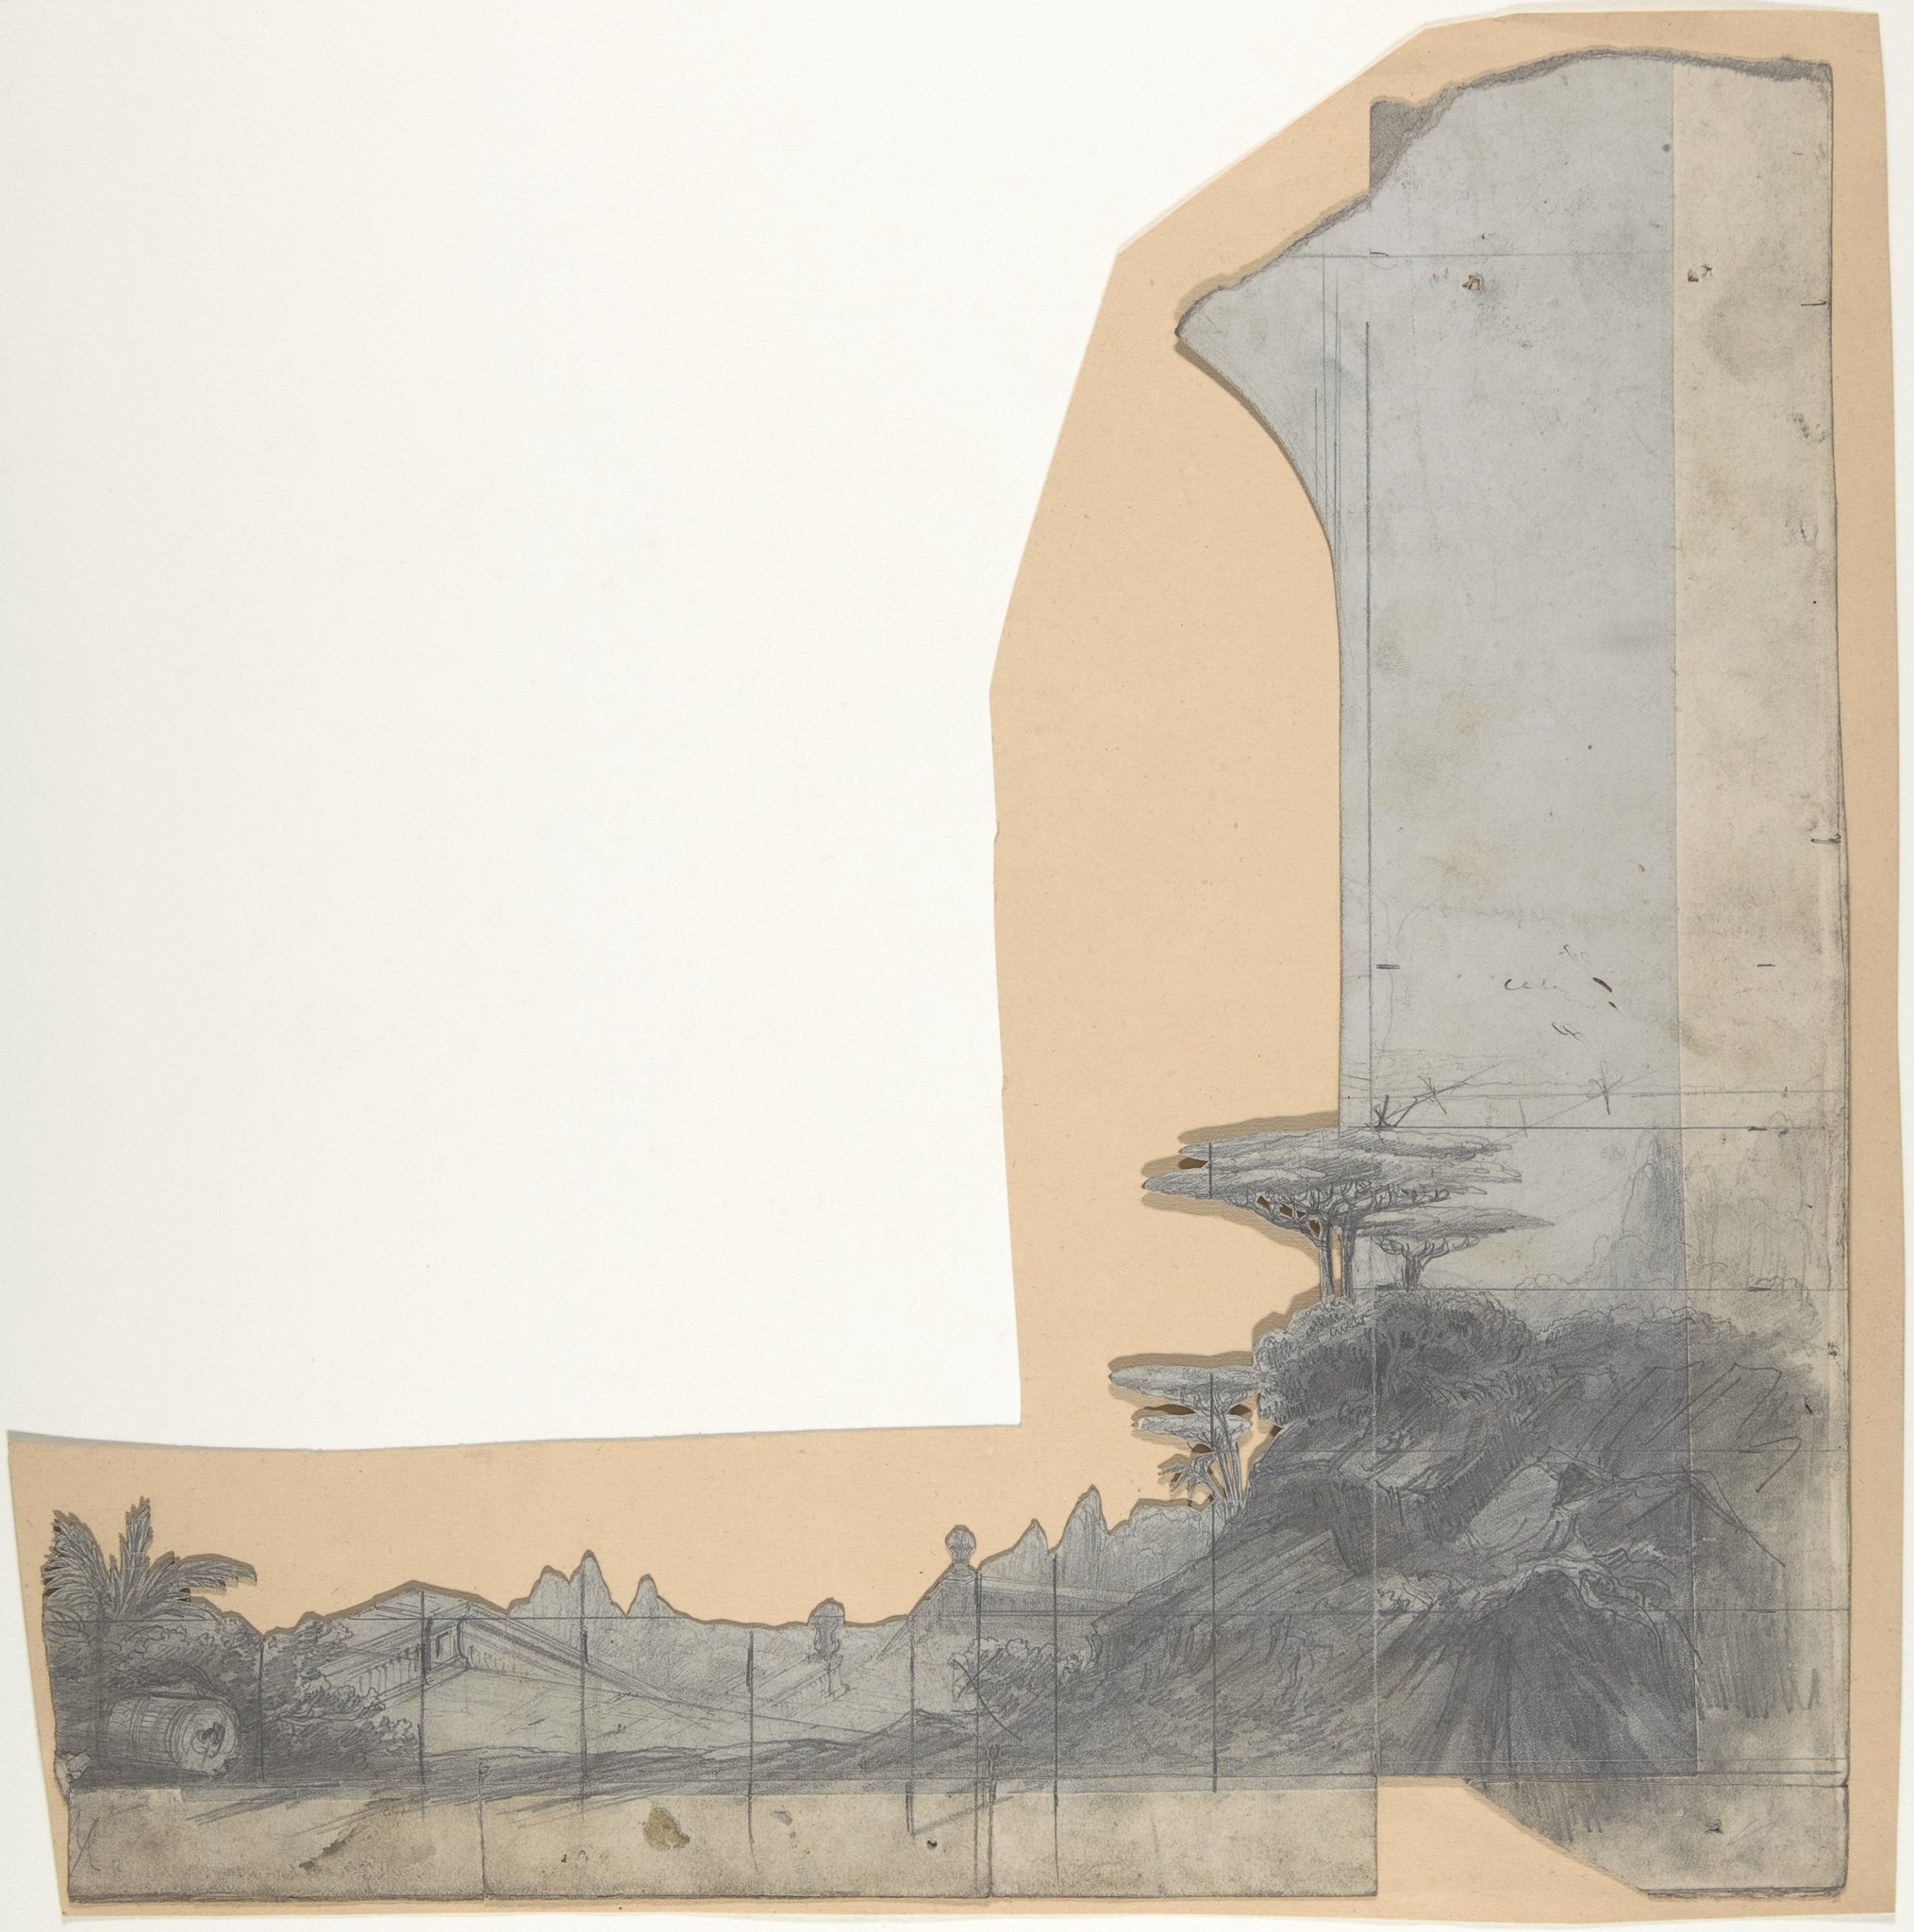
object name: drawing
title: Design for a Stage Set at the Opéra, Paris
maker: eugène cicéri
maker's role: artist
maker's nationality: french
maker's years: 1813-1890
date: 1840-1890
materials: graphite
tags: stage design